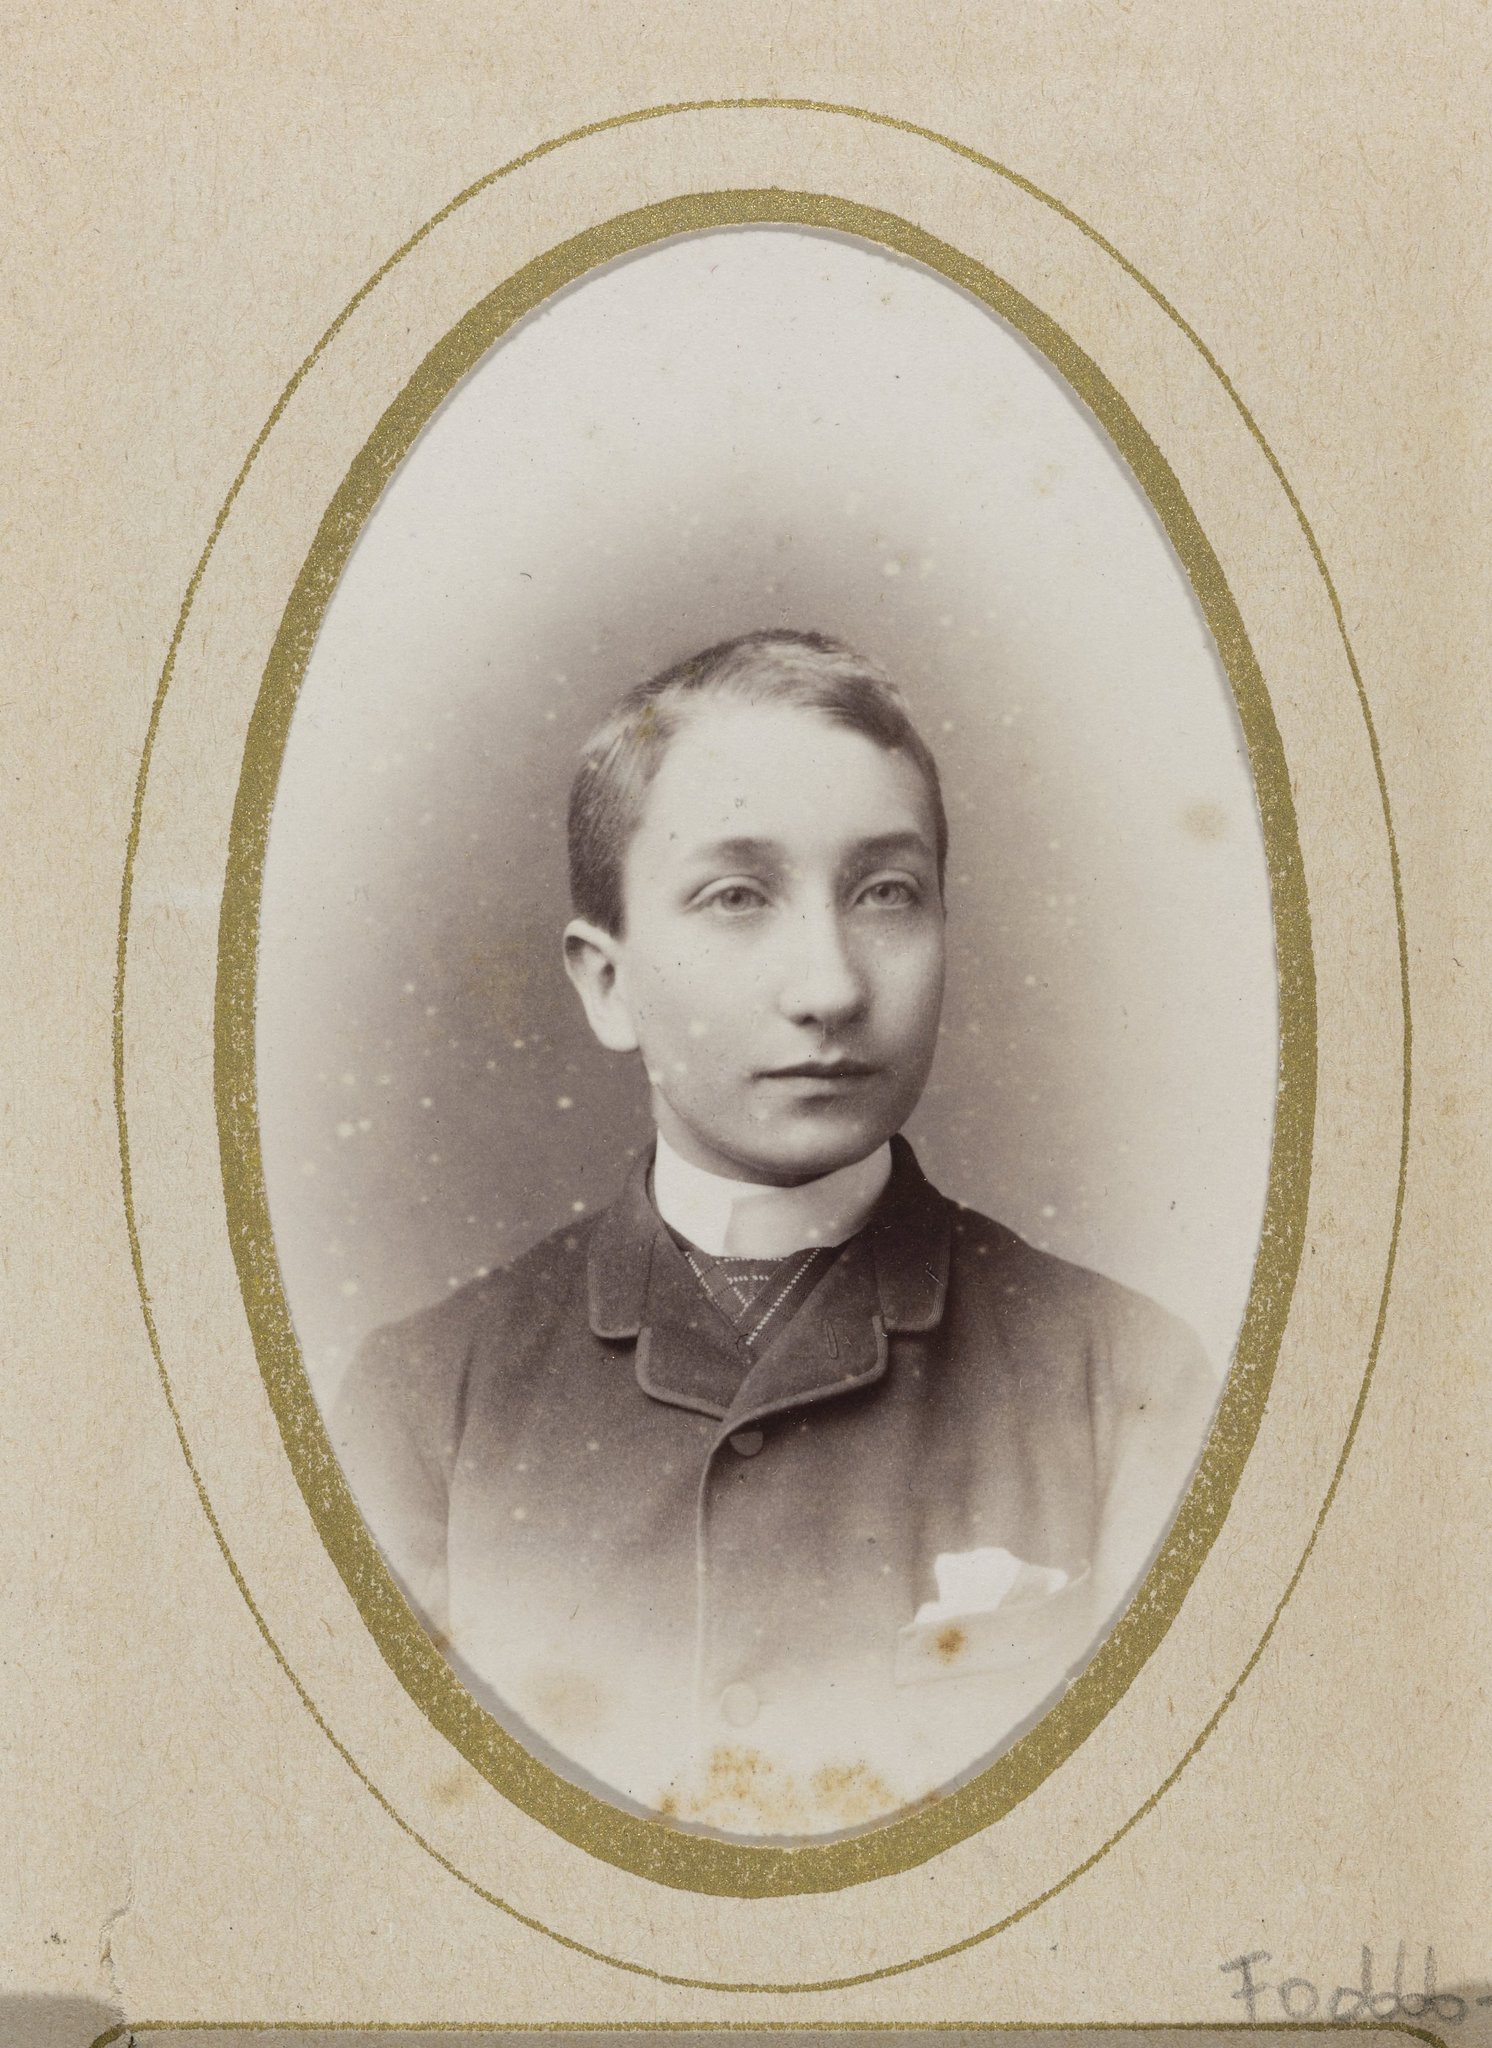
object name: album leaf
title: Portret van een jonge man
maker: johan christiaan reesinck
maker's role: fotograaf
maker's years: 1838-1922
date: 1863-1900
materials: cardboard, photographic support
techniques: albumen print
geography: zutphen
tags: historical persons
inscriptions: inscription: ‘J. C. Reesinck/ ZUTPHEN/ Berkelkade B. 300./ Het cliché blijft voor nabestelling bewaard.’